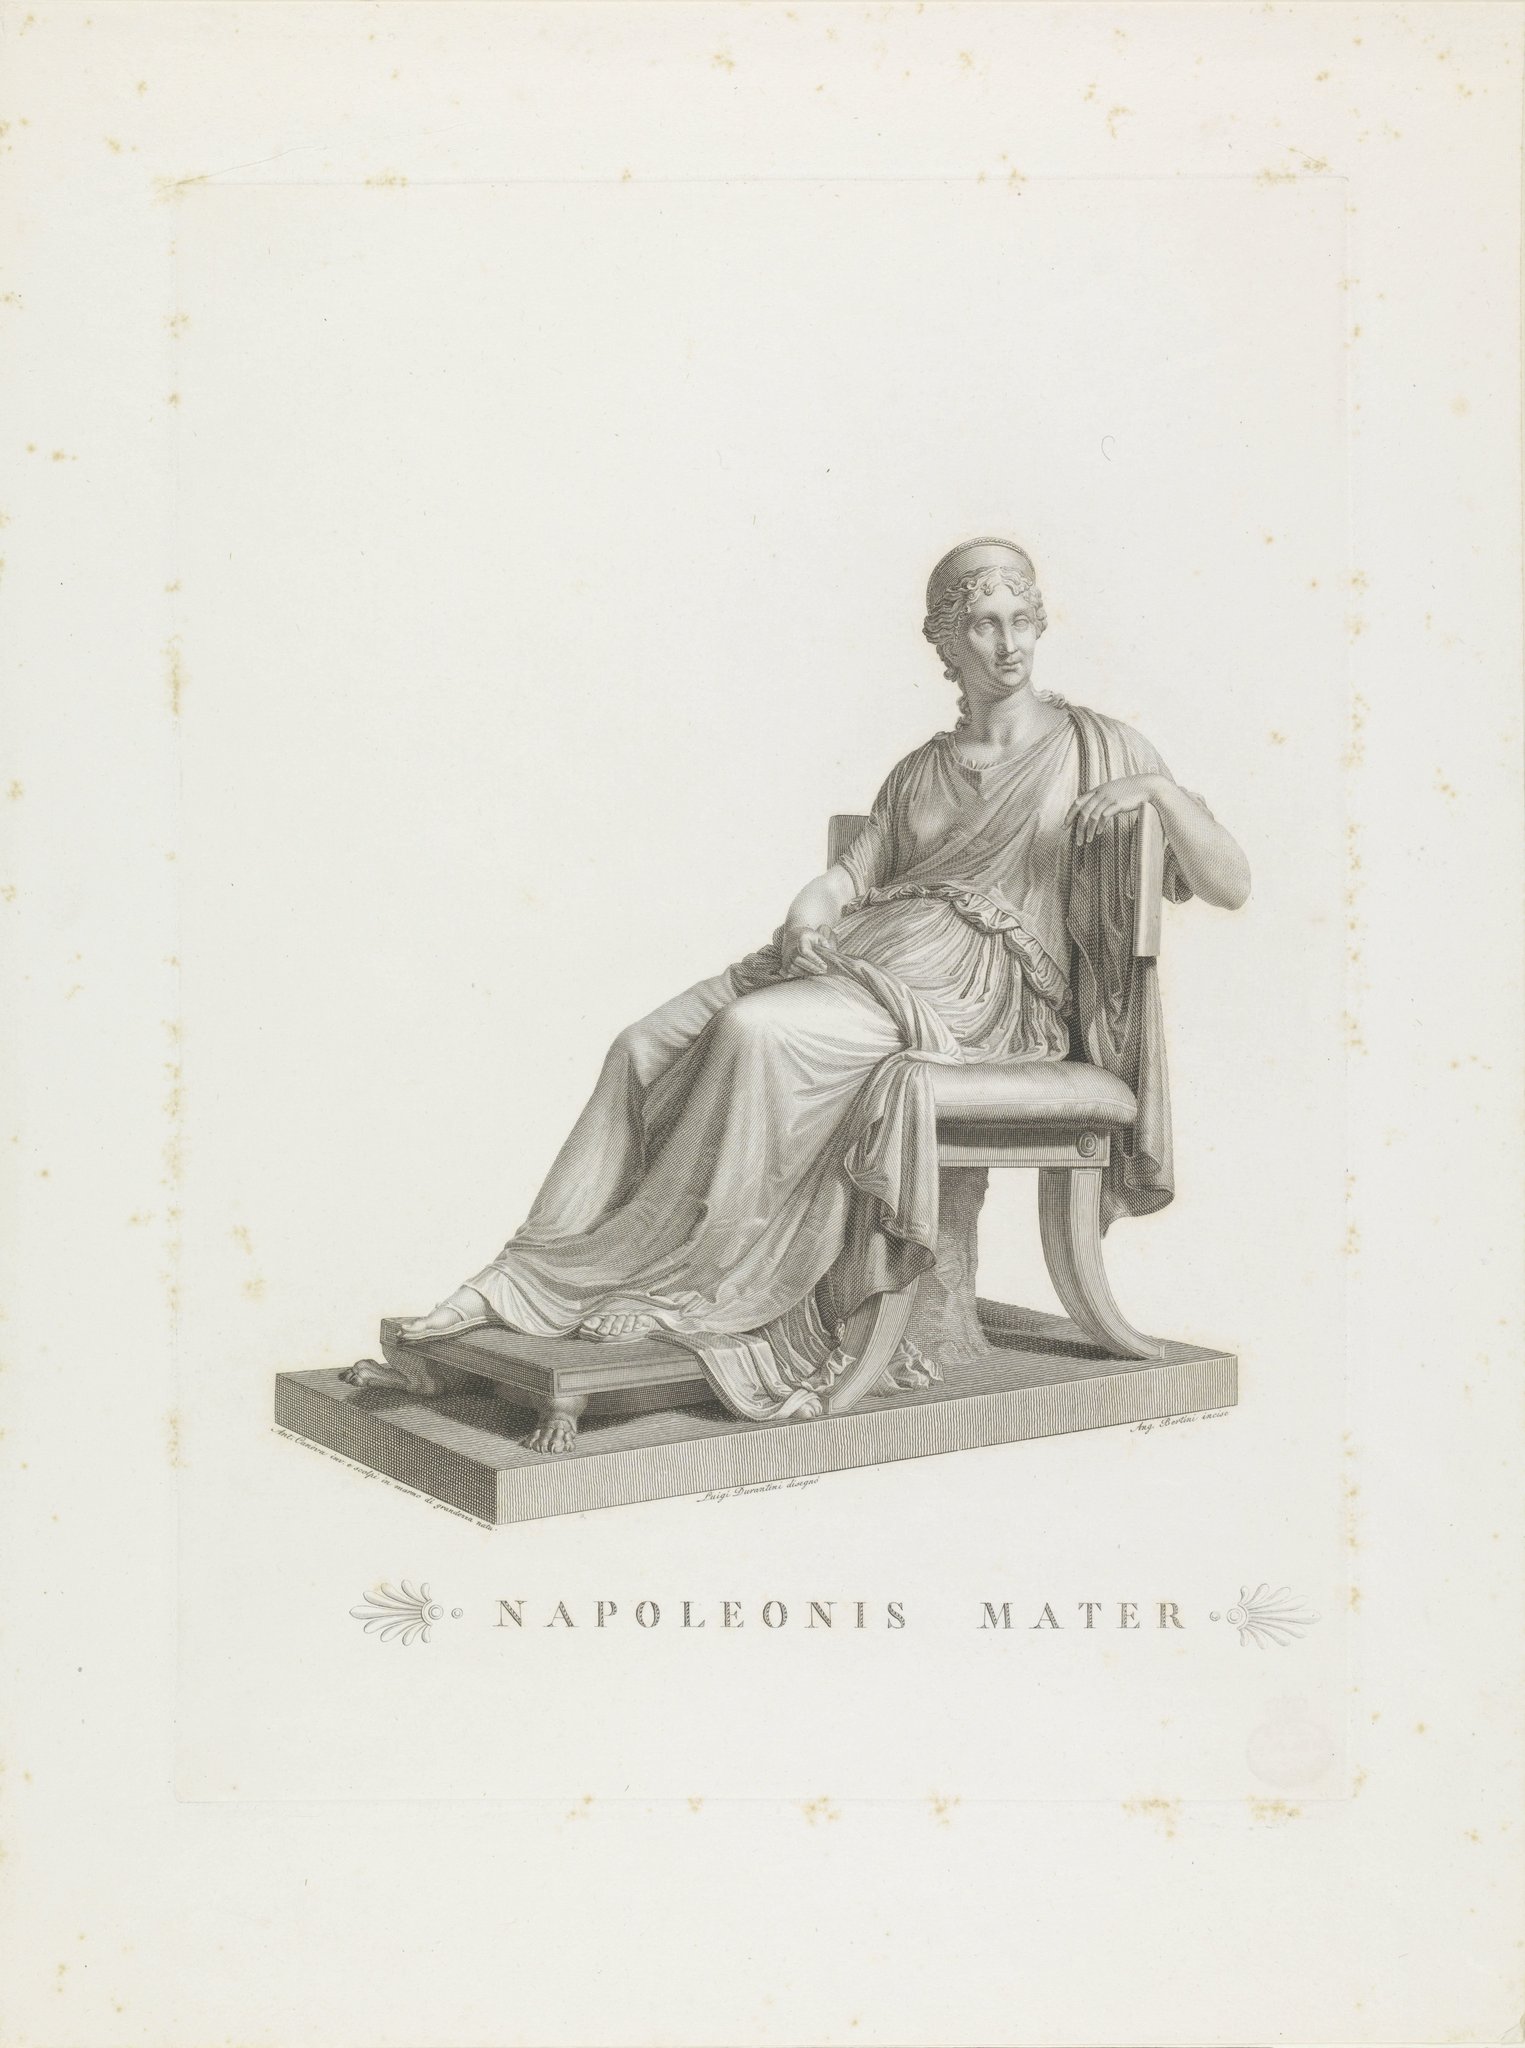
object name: print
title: Standbeeld van de moeder van Napoleon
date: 1793-1838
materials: paper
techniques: engraving, etching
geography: italy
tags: historical persons, piece of sculpture, reproduction of a piece of sculpture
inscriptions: collector's mark: Lugt 12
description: Standbeeld van Maria Laetitia Ramolino, de moeder van Napoleon Bonaparte, zittend op een stoel, door de Italiaanse beeldhouwer Antonio Canova.